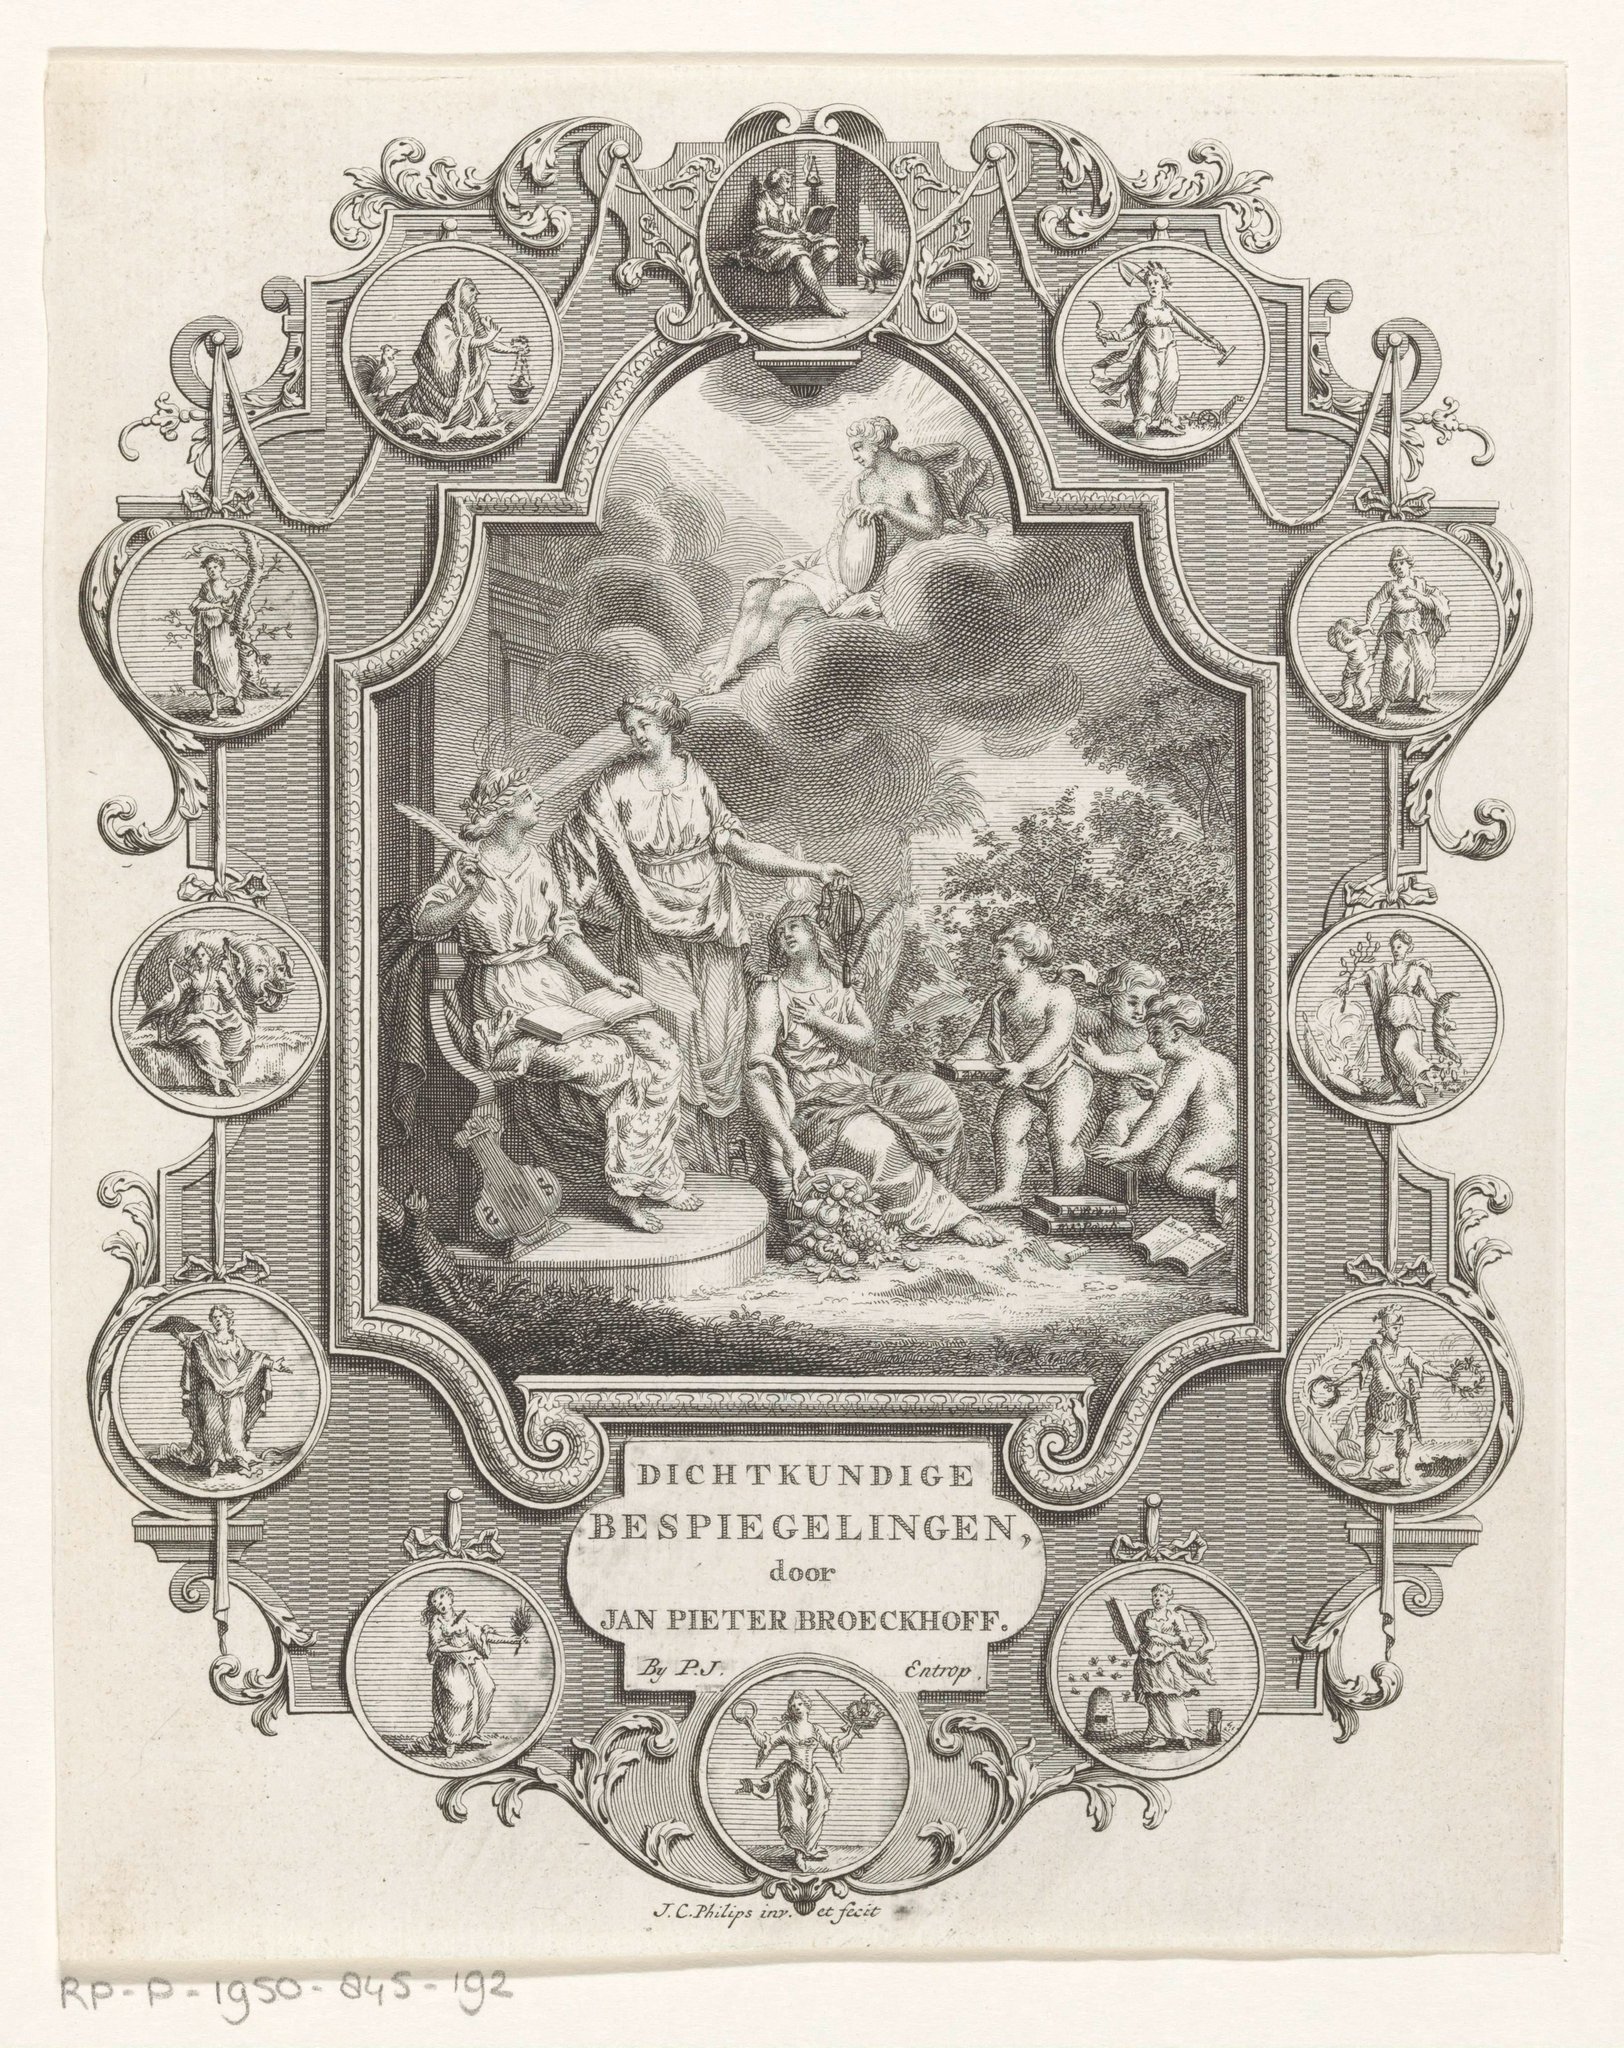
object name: titelblad, titelpagina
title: Titelpagina voor: Jan Pieter Broeckhoff, Dicht- en zedekundige zinnebeelden en bespiegelingen, 1770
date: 1770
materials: paper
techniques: engraving, etching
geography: amsterdam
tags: temperance, 'temperantia'; 'temperanza' (ripa) ~ one of the four cardinal virtues, truth; 'verità' (ripa), symbolic representations, allegories and emblems ~ poetry; 'poesia' (ripa)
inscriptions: collector's mark: Lugt 2228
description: Poëzie kijkt op naar de gepersonifieerde Goddelijke Waarheid, die op een wolk zit. De personificatie van Matigheid wijst op putti die boeken naar Poëzie brengen. Een vrouw met vlam boven het hoofd (die symbool staat voor geloofsijver) wijst op een hoorn des overvloeds. De voorstelling is gevat in een cartouche dat is gedecoreerd met medaillons waarin deugden zijn afgebeeld.